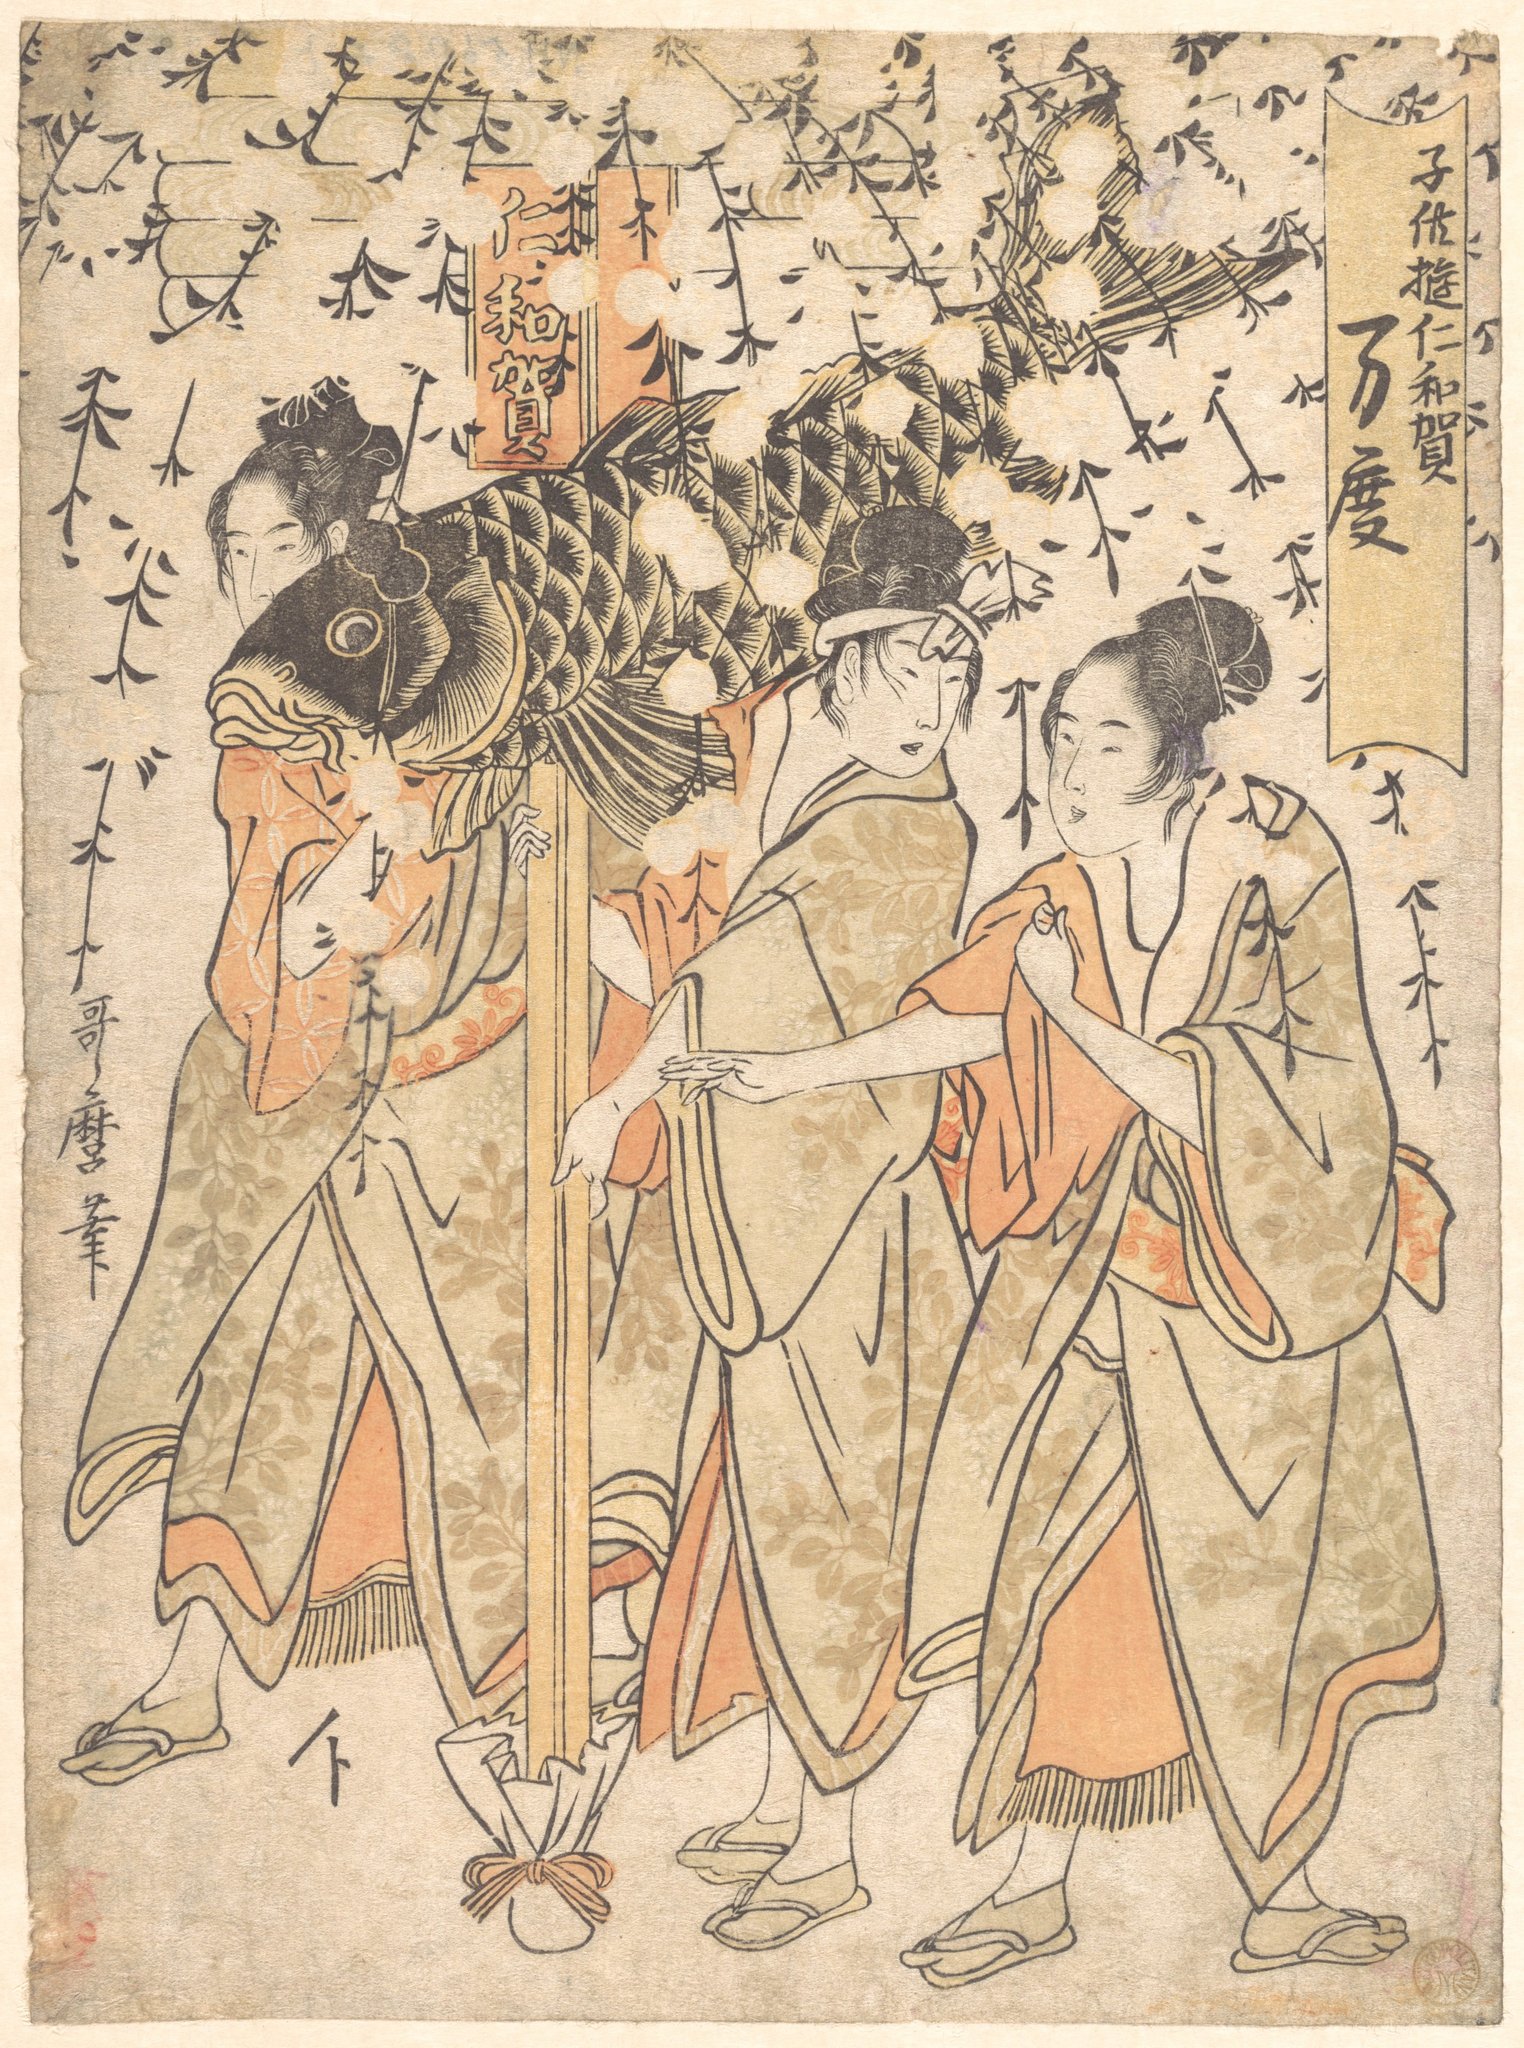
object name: print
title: Lantern Float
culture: japanese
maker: kitagawa utamaro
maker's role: artist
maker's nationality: japanese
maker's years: 1754-1806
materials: ink, paper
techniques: woodblock print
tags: human figures,fish